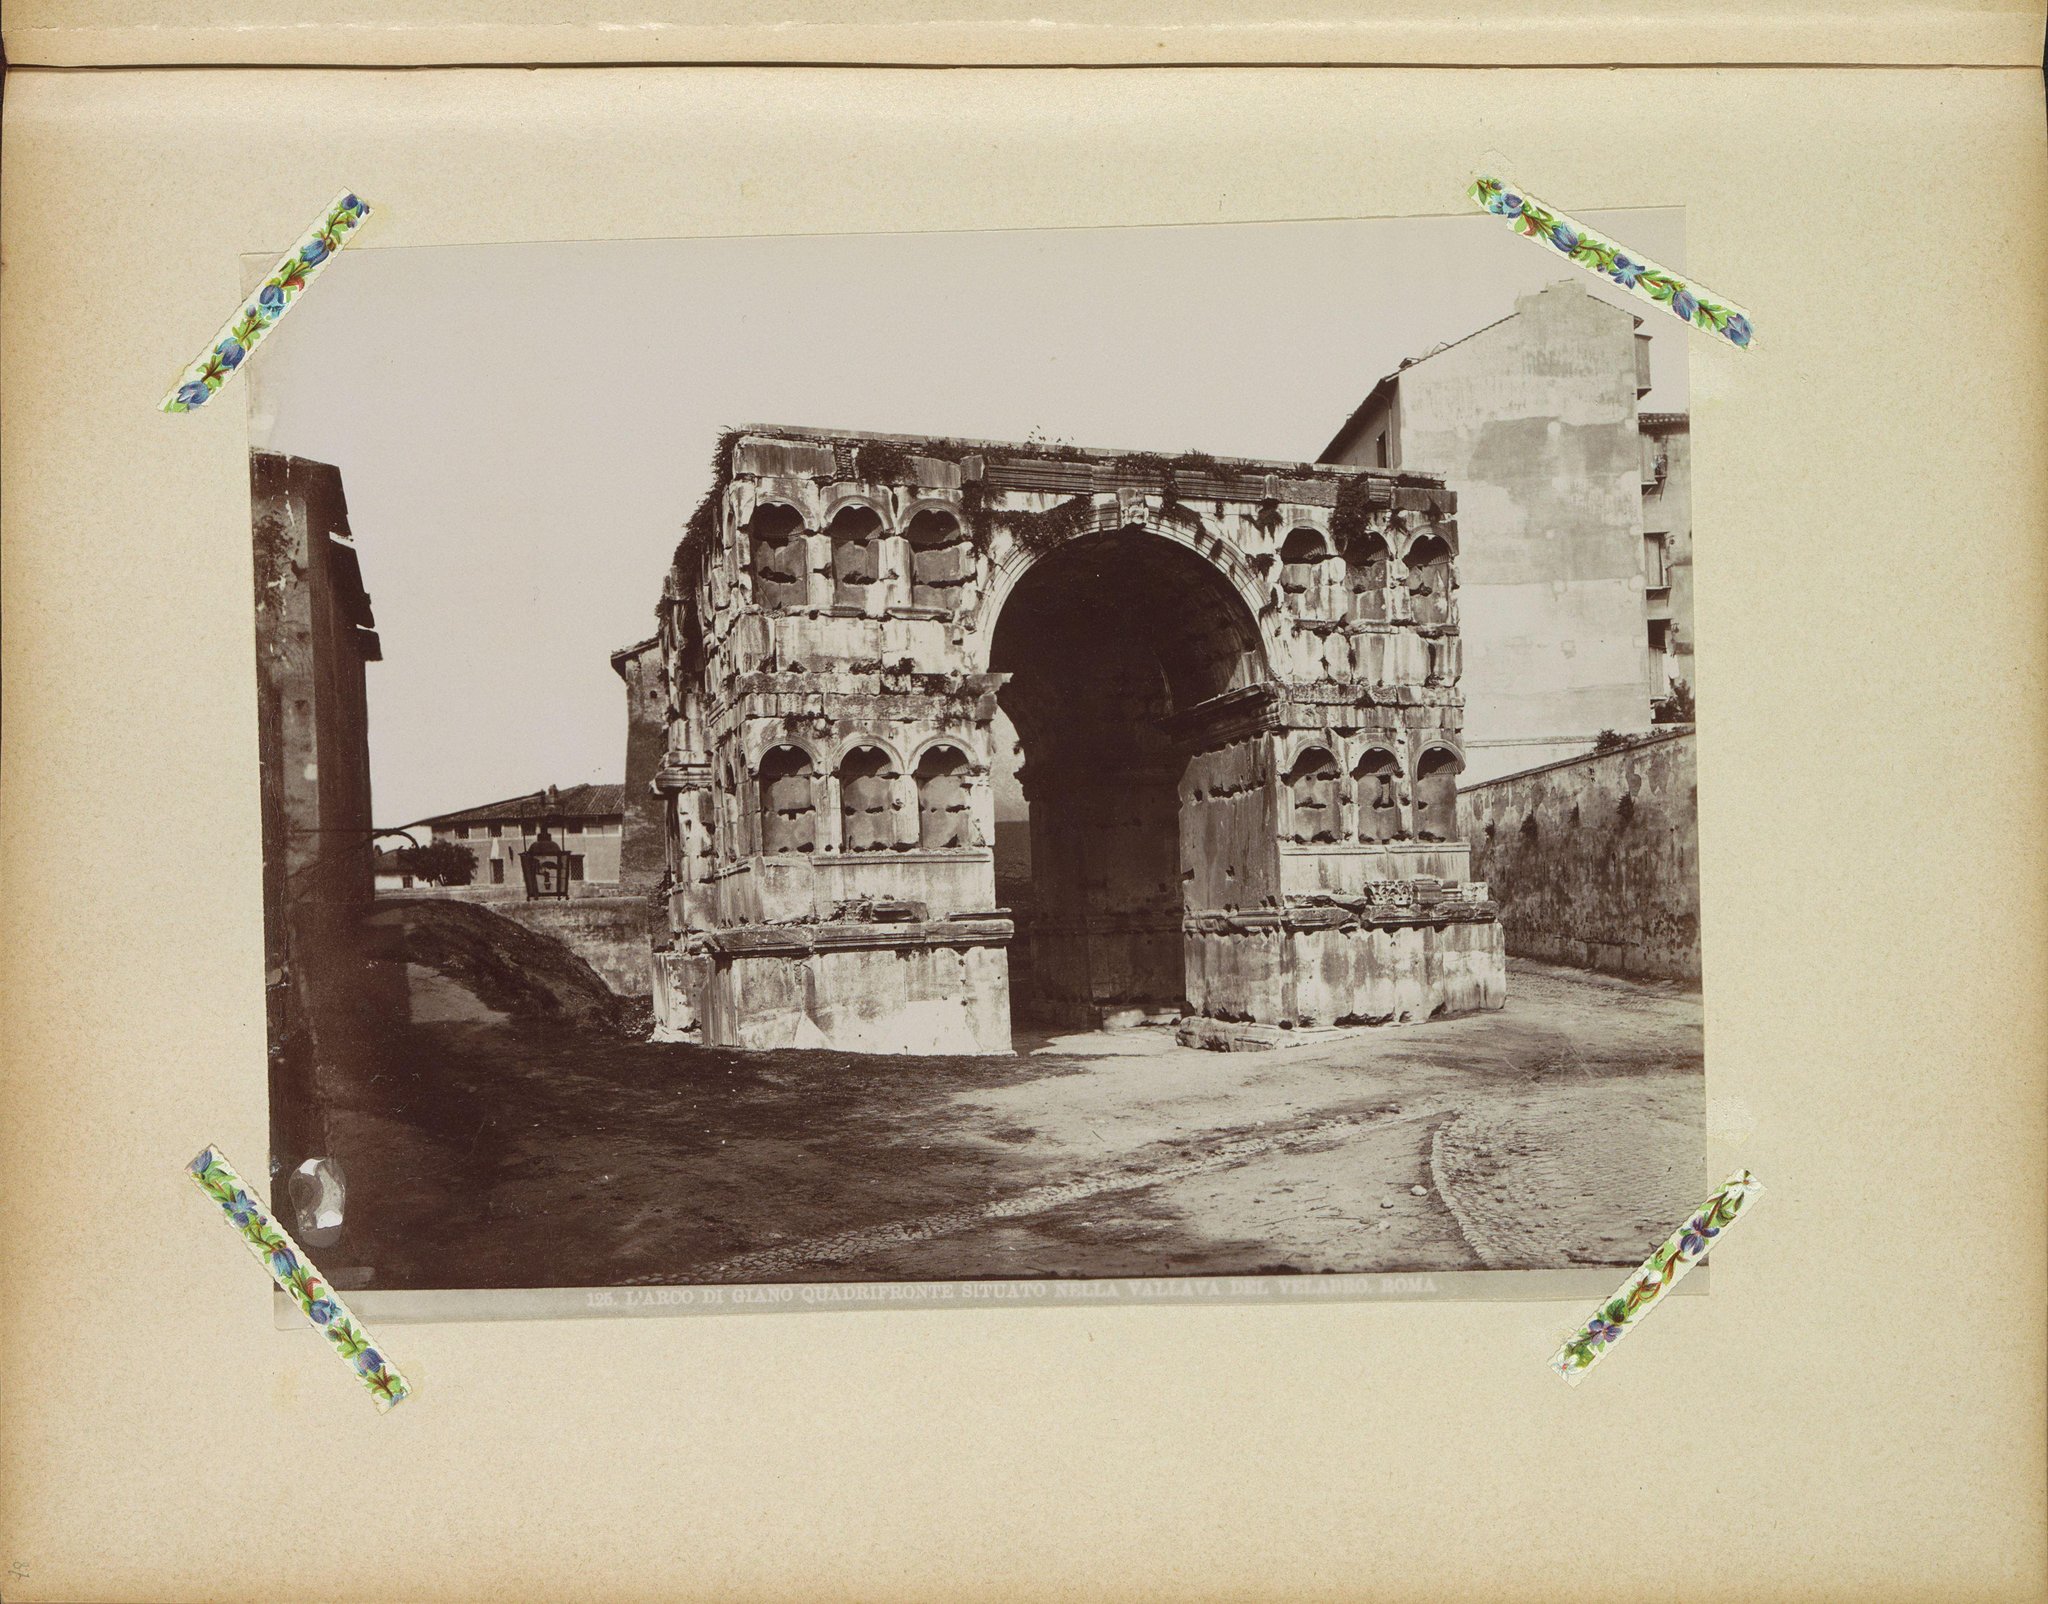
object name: photograph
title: Boog van Janus in Rome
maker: Anonymous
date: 1860-1900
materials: photographic support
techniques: albumen print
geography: rome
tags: triumphal arch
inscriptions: number: ‘125’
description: Onderdeel van Fotoalbum met opnames van bezienswaardigheden in Italiaanse steden en van kunstwerken.